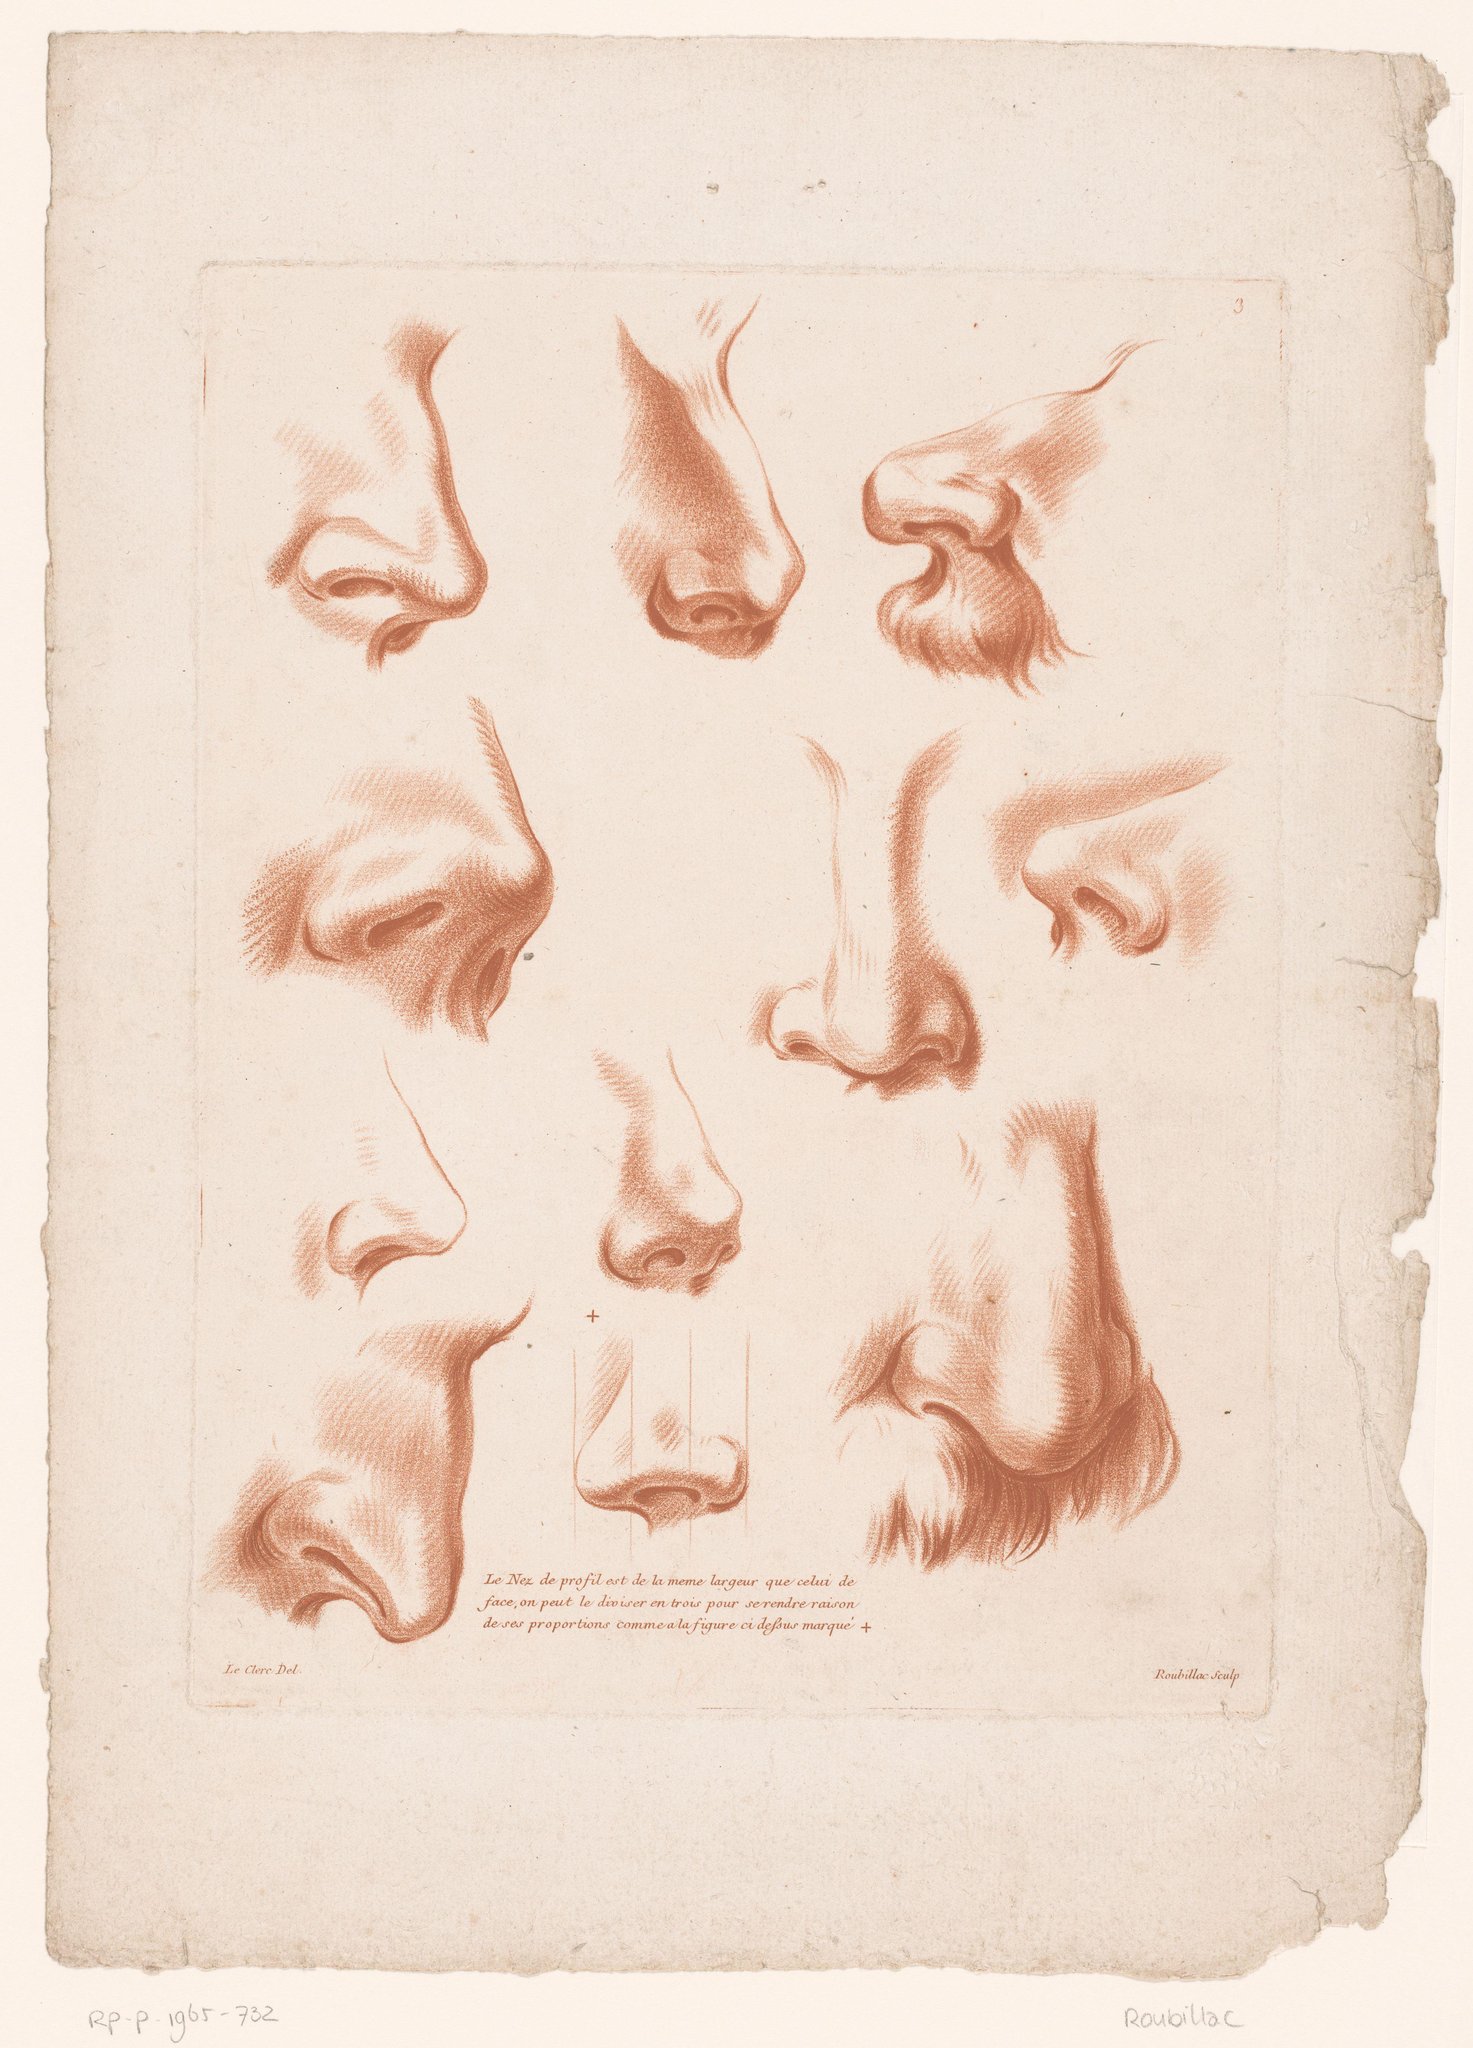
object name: print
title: Elf neuzen vanuit verschillende perspectieven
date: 1784-1796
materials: paper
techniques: printmaking, etching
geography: paris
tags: drawing, sketch, parts of the face: nose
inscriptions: collector's mark: Lugt 2228